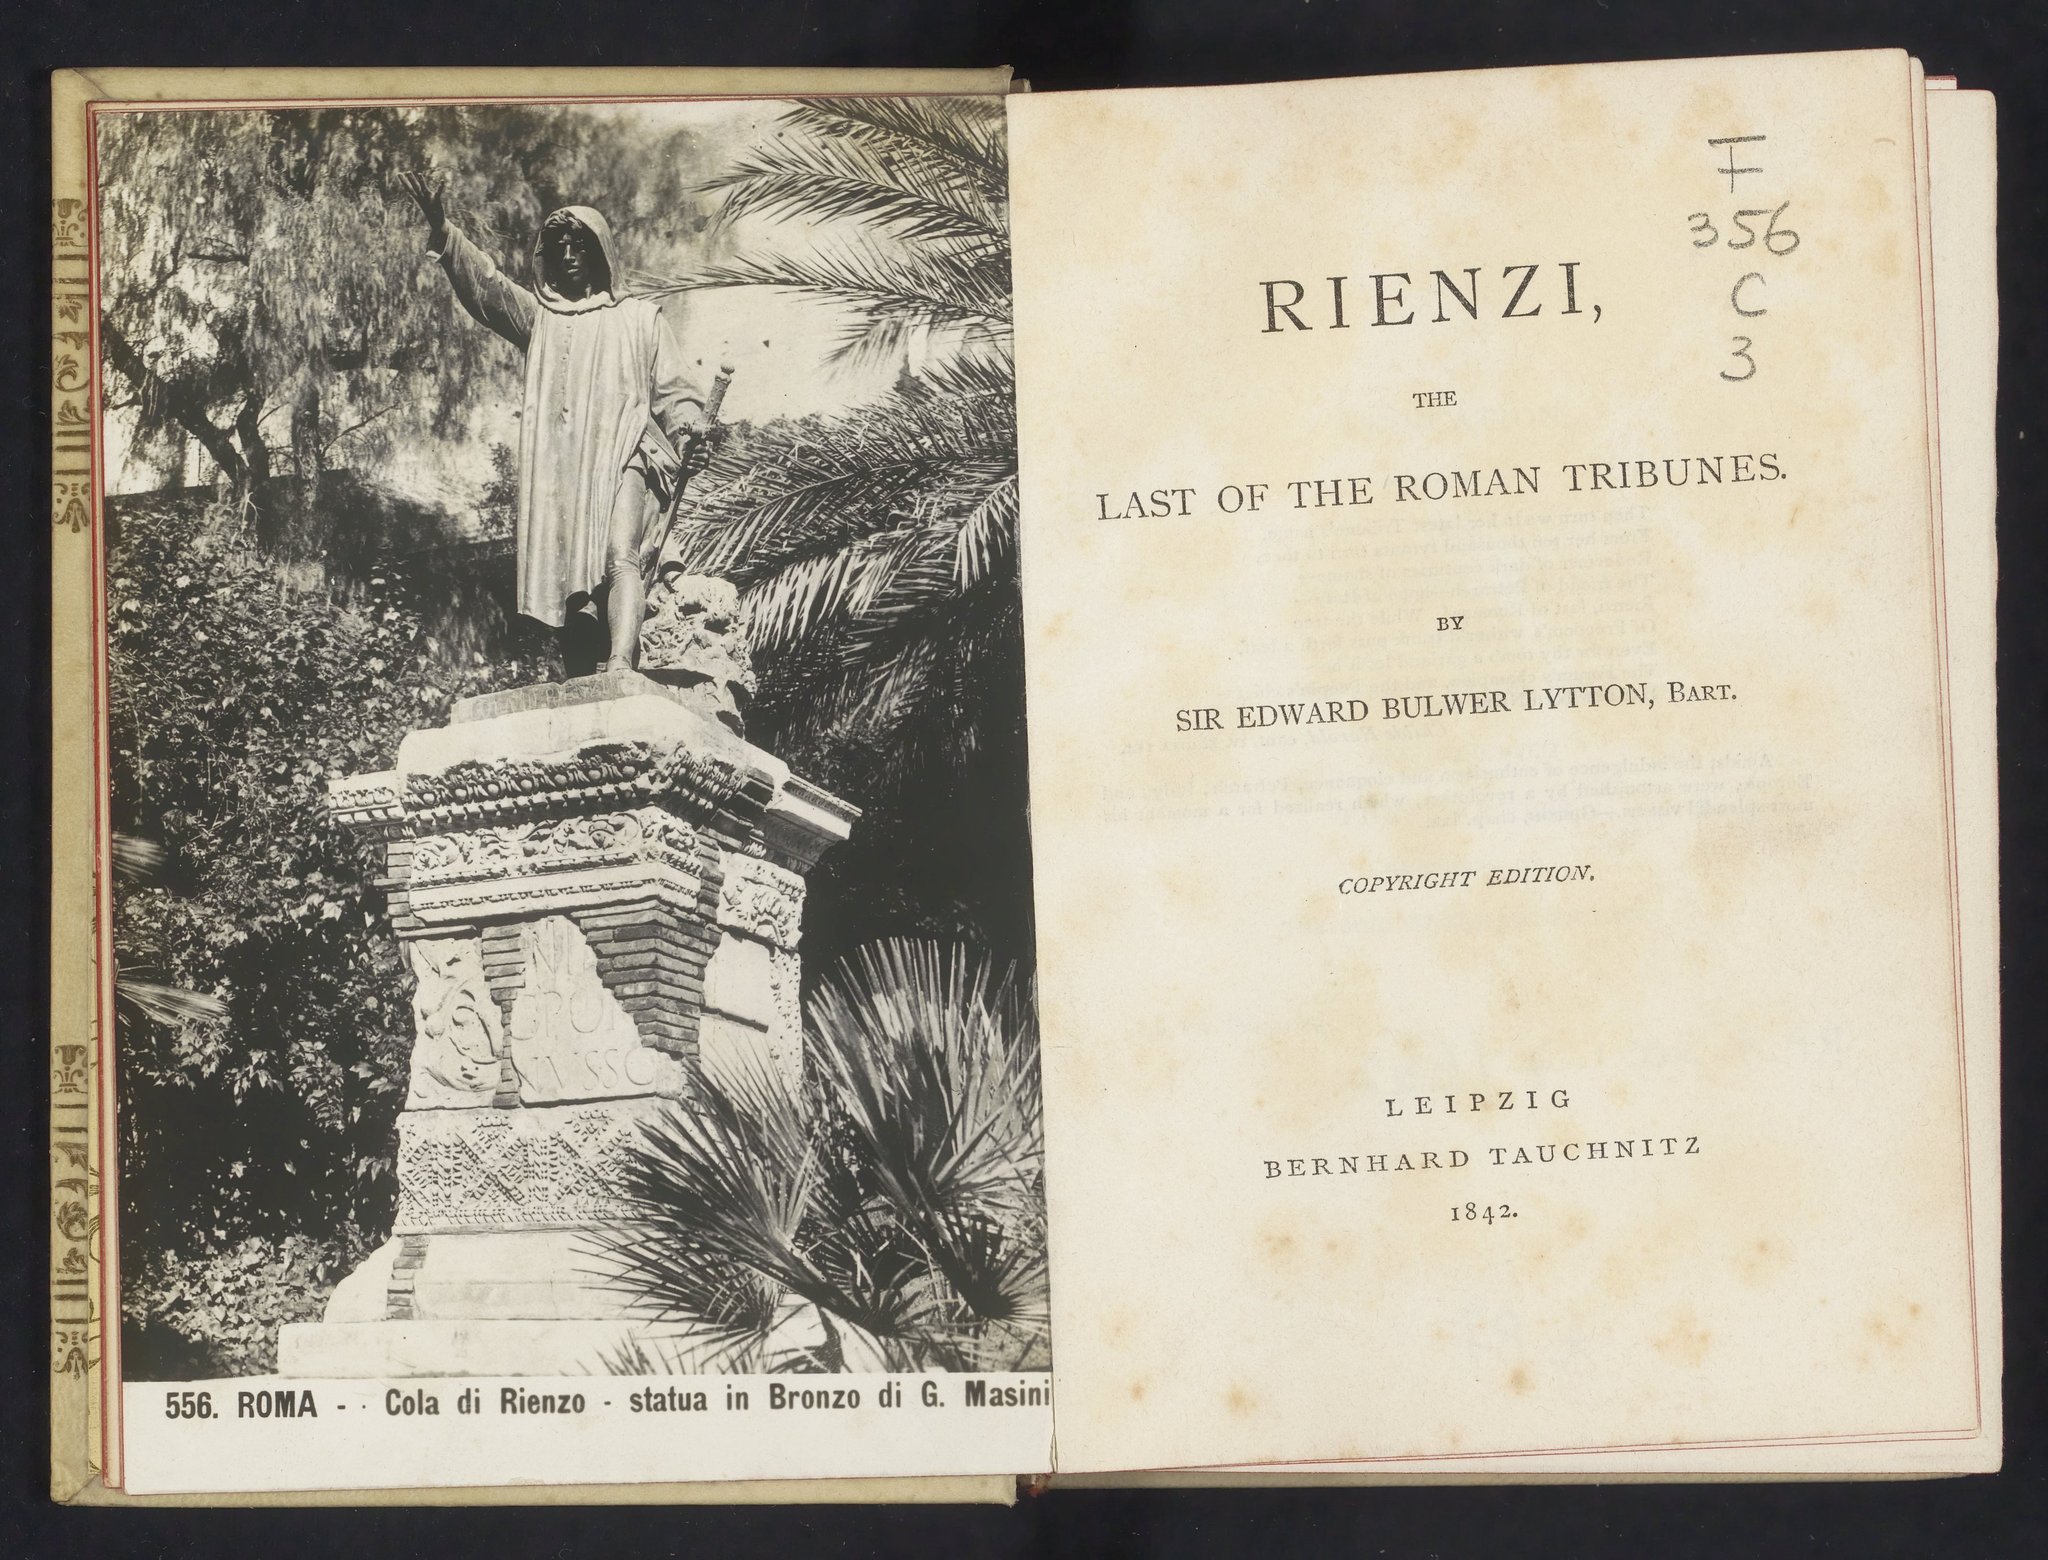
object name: book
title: Rienzi, the last of the Roman Tribunes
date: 1842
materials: cardboard, paper, photographic support, parchment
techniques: gelatin silver print, printing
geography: leipzig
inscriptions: name: ‘'ex libris' michael O'Hara’